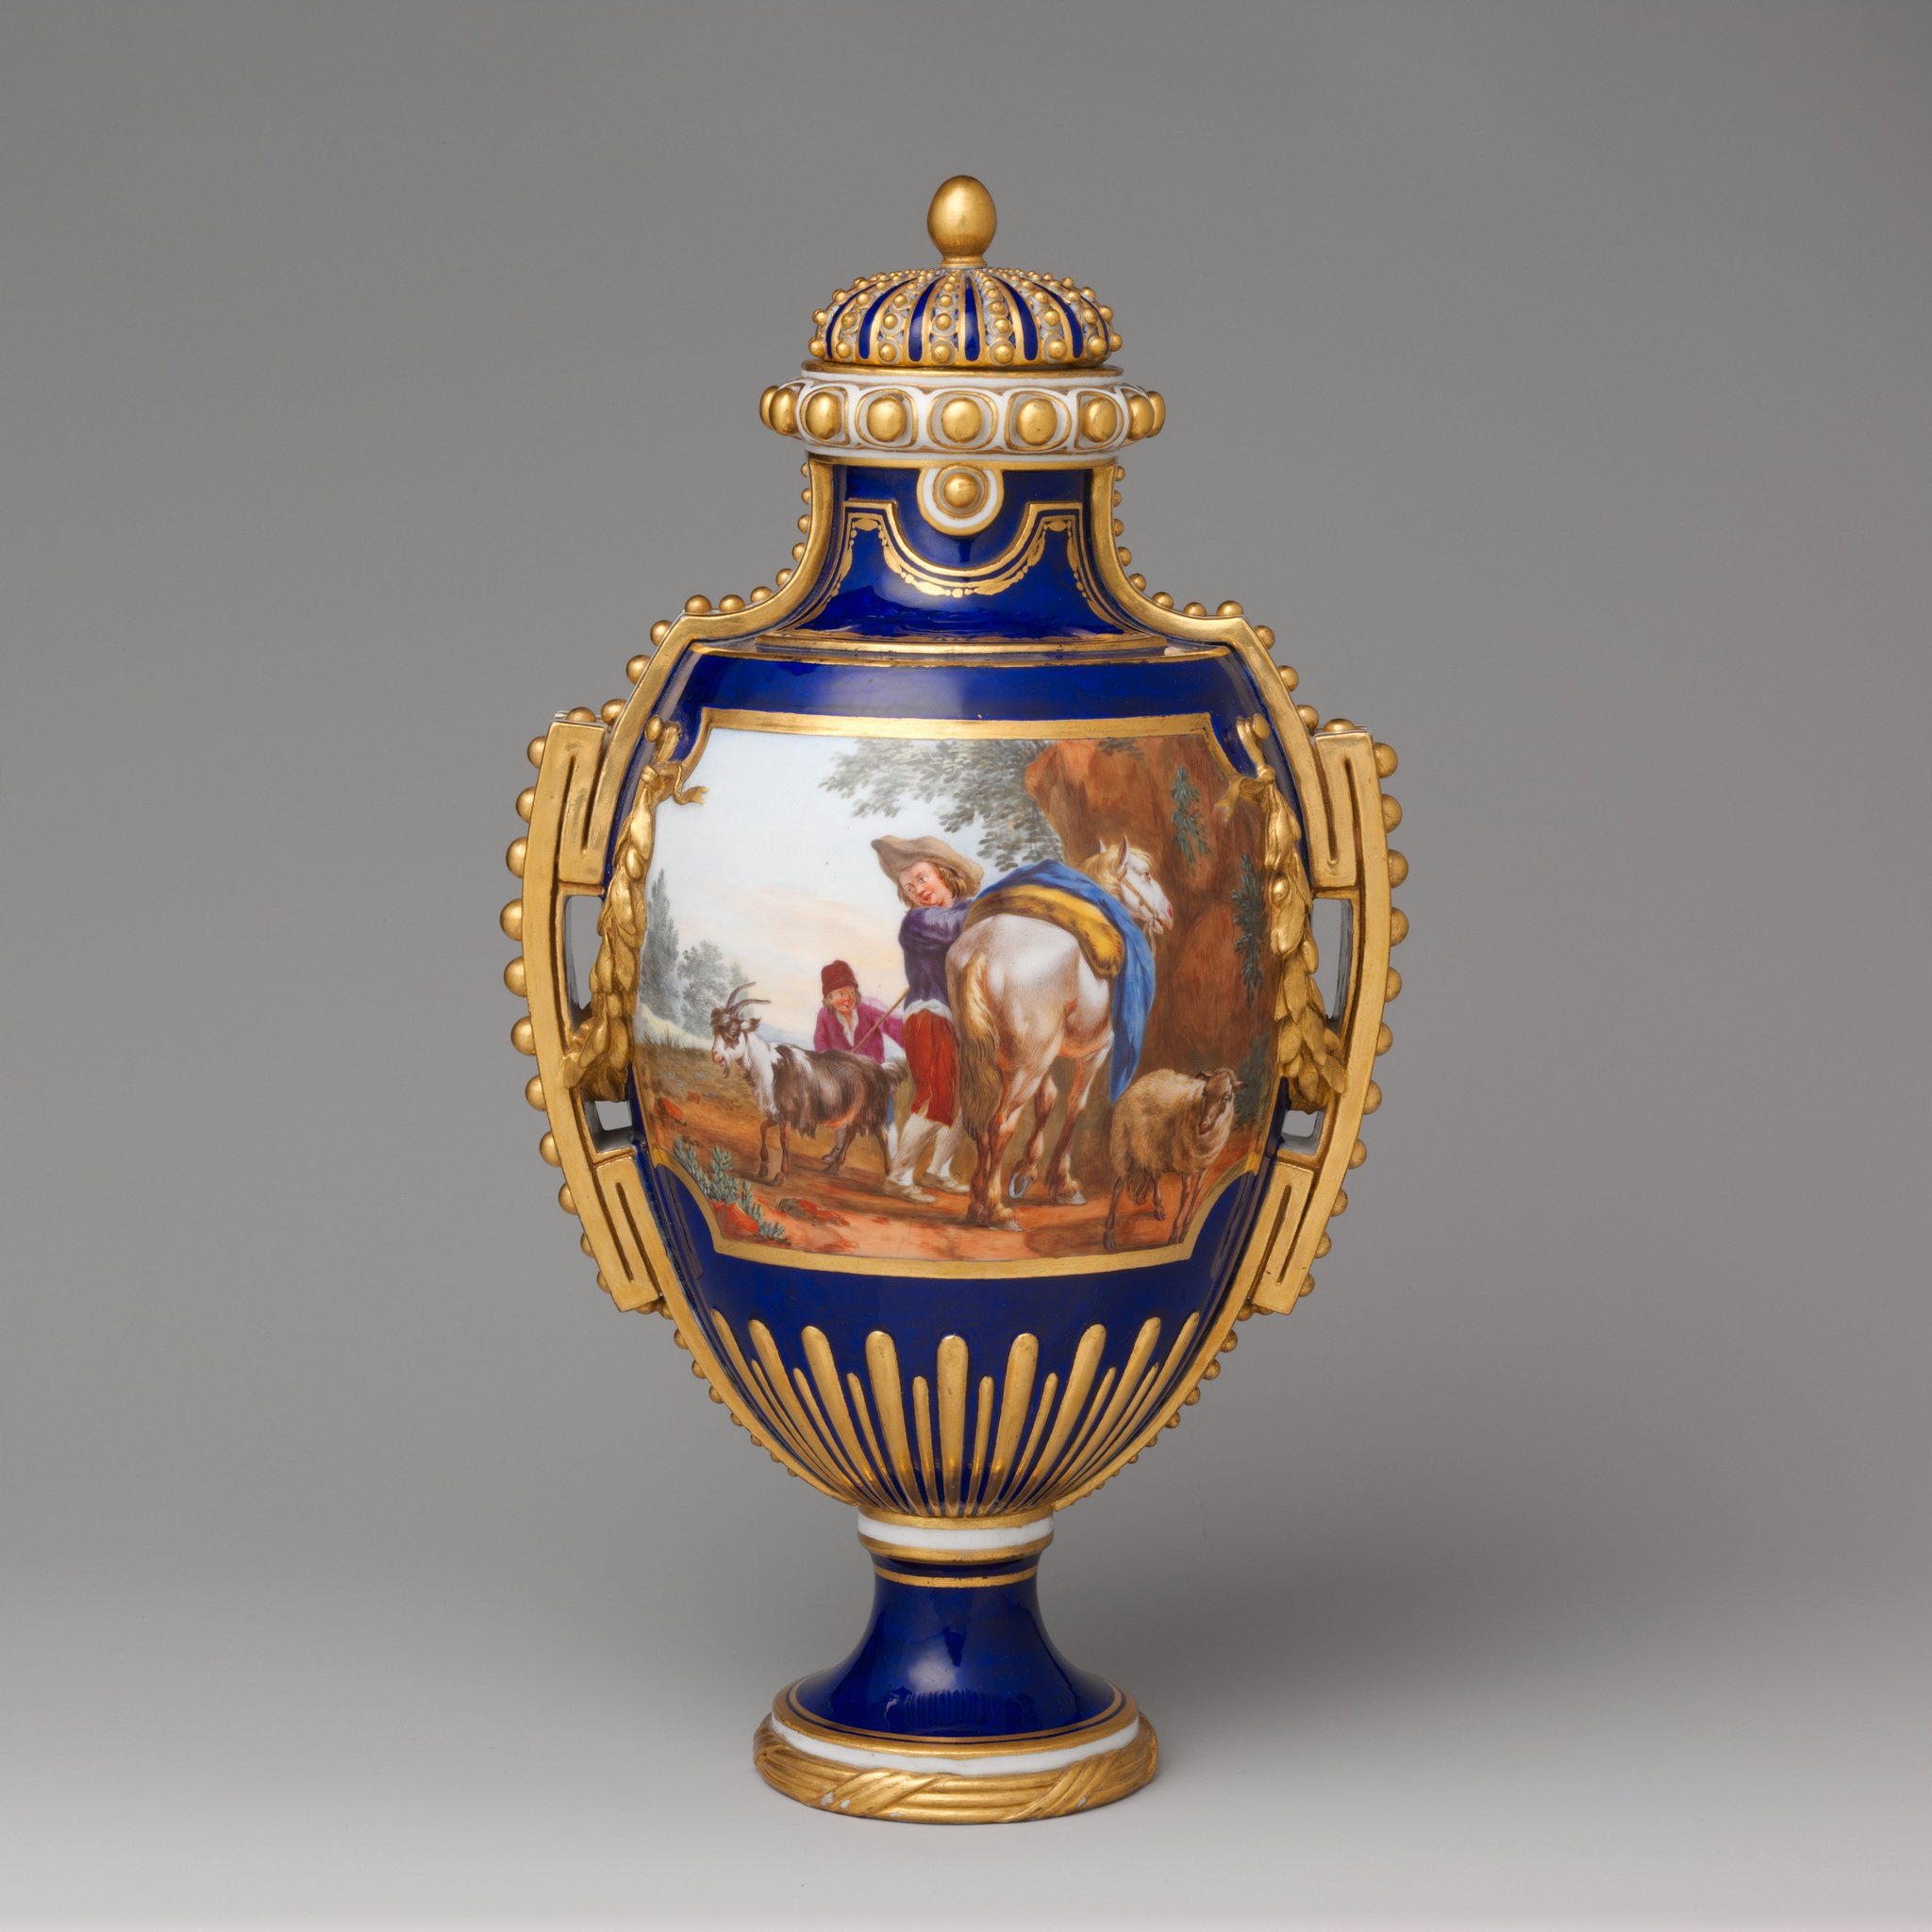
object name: vase with cover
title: Vase with cover (vase à panneaux or à perles) (one of a pair)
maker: sèvres manufactory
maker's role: manufactory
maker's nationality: french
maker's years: 1740-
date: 1766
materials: soft paste porcelain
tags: men,goats,horses,sheep